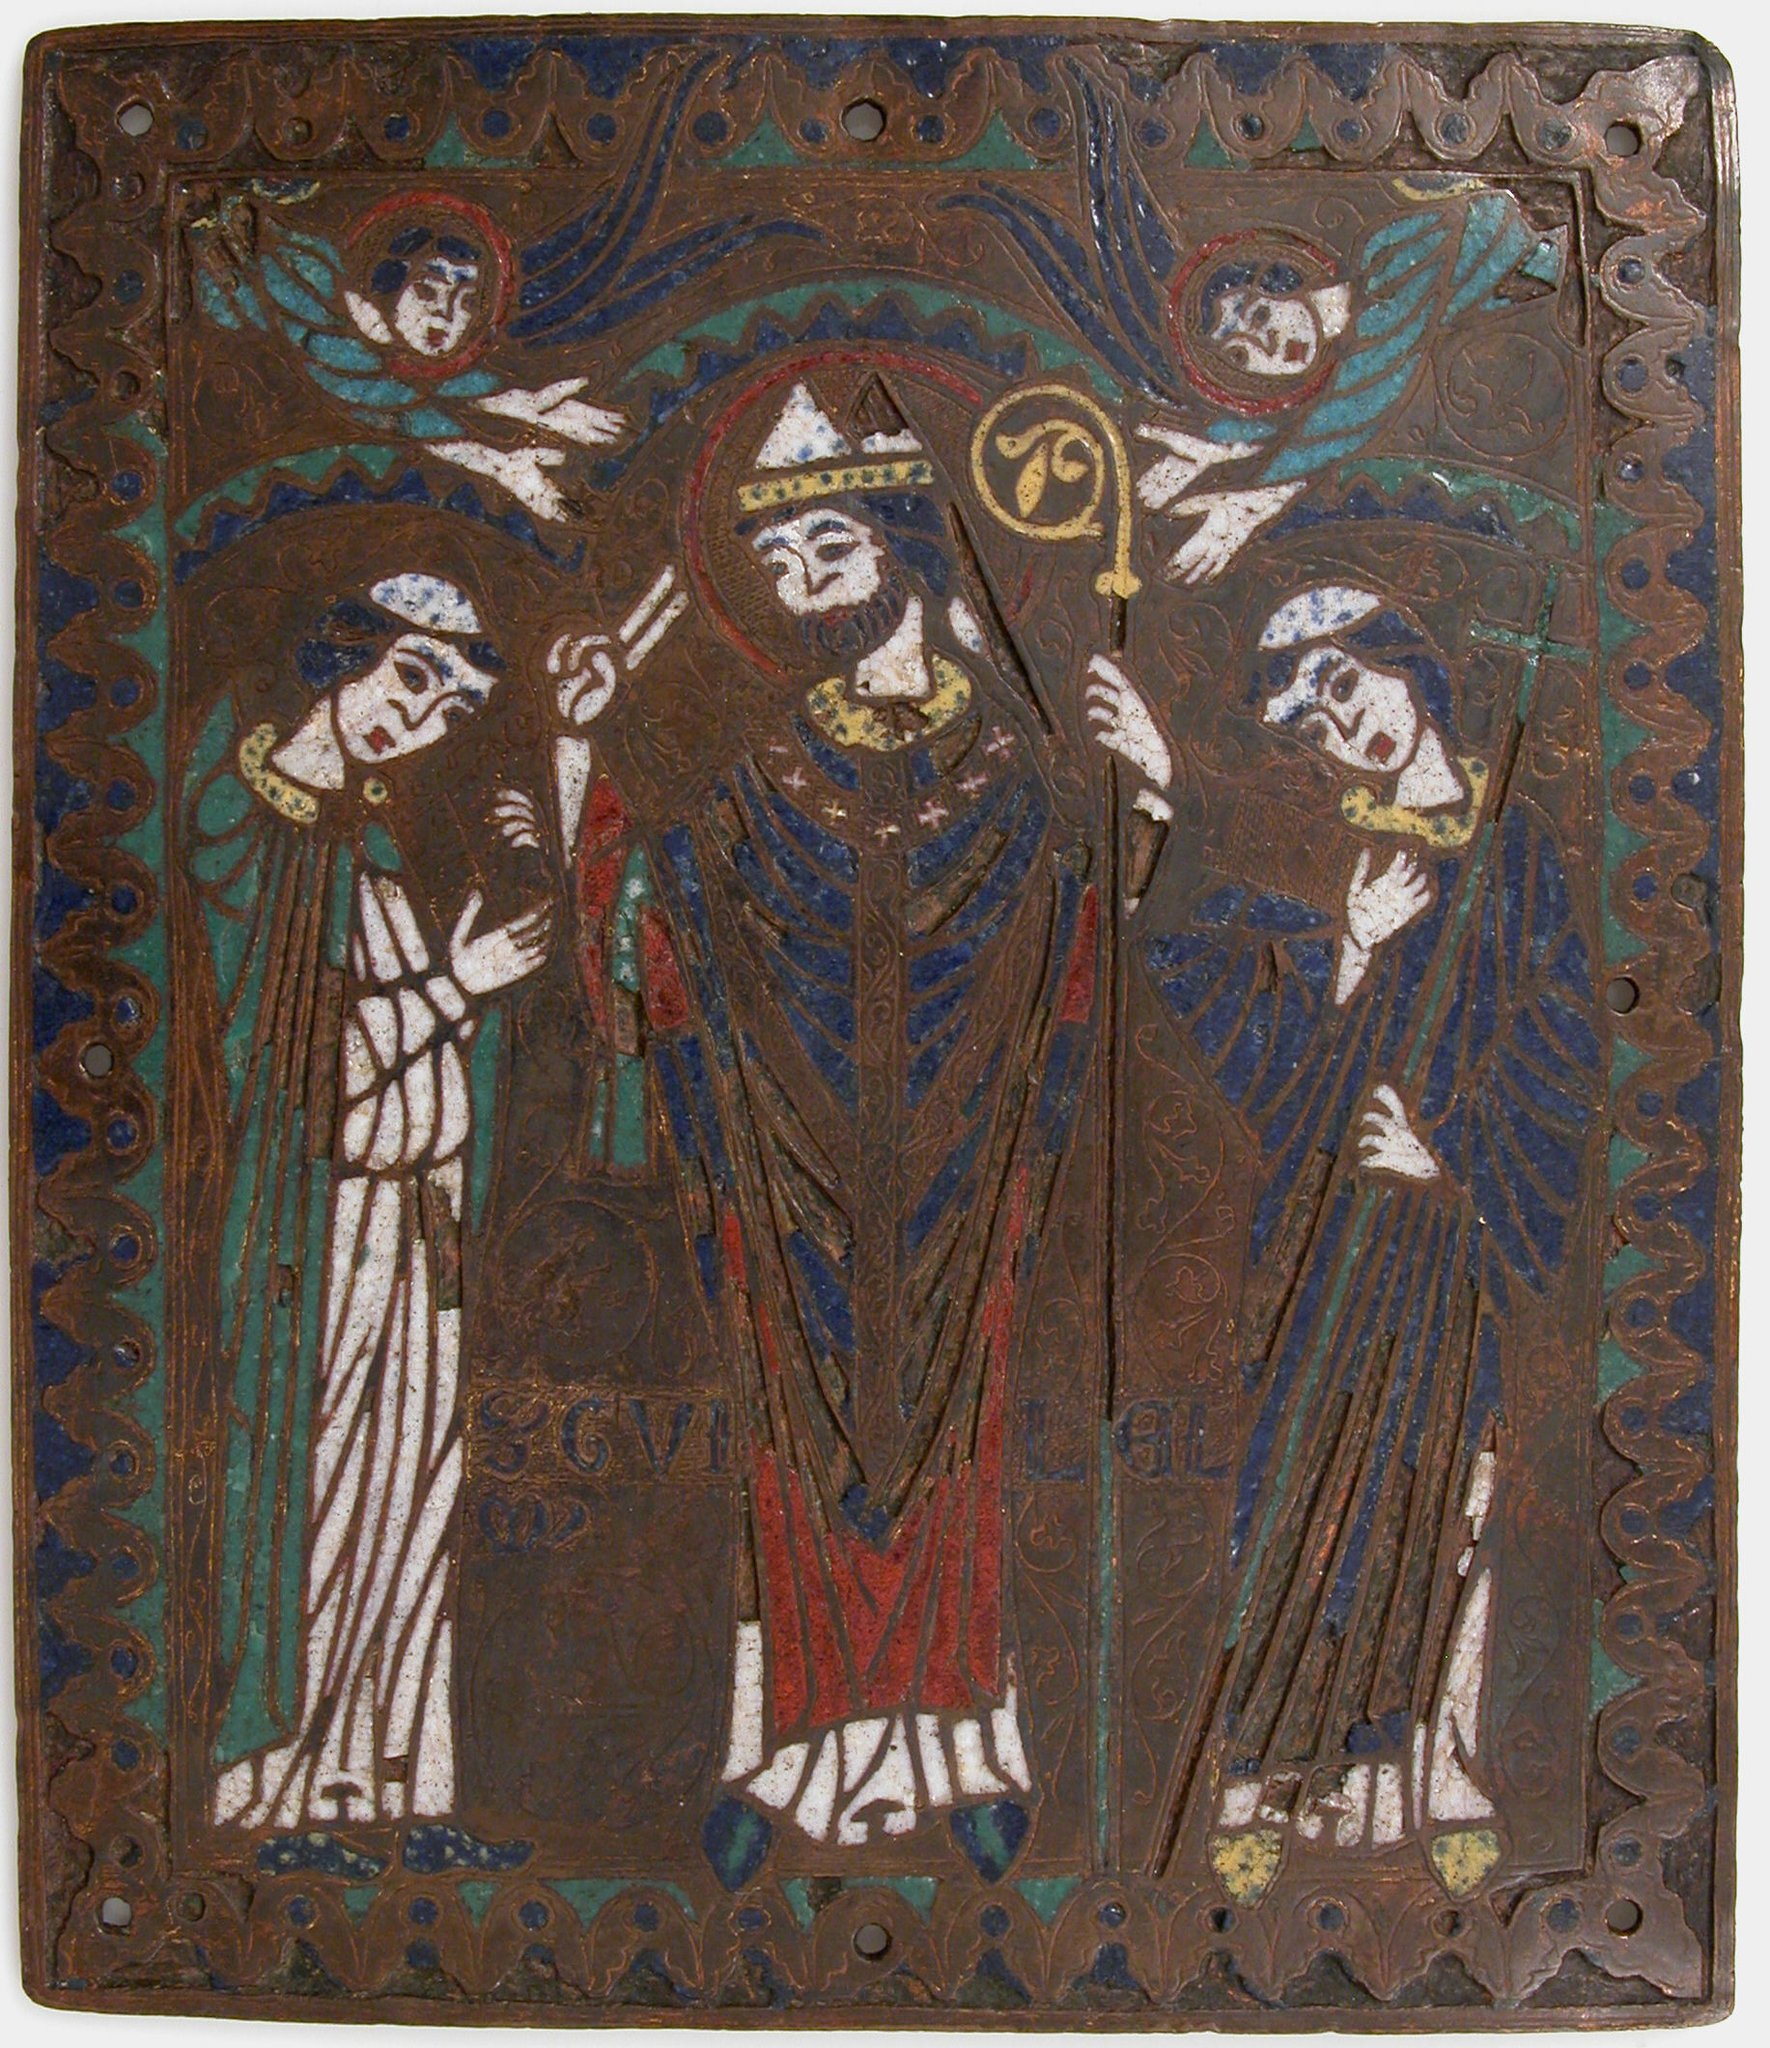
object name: plaque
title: Plaque with Saint William of Bourges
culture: french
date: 1218-1225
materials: copper, enamel, gilt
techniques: enamel, engraving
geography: france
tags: men